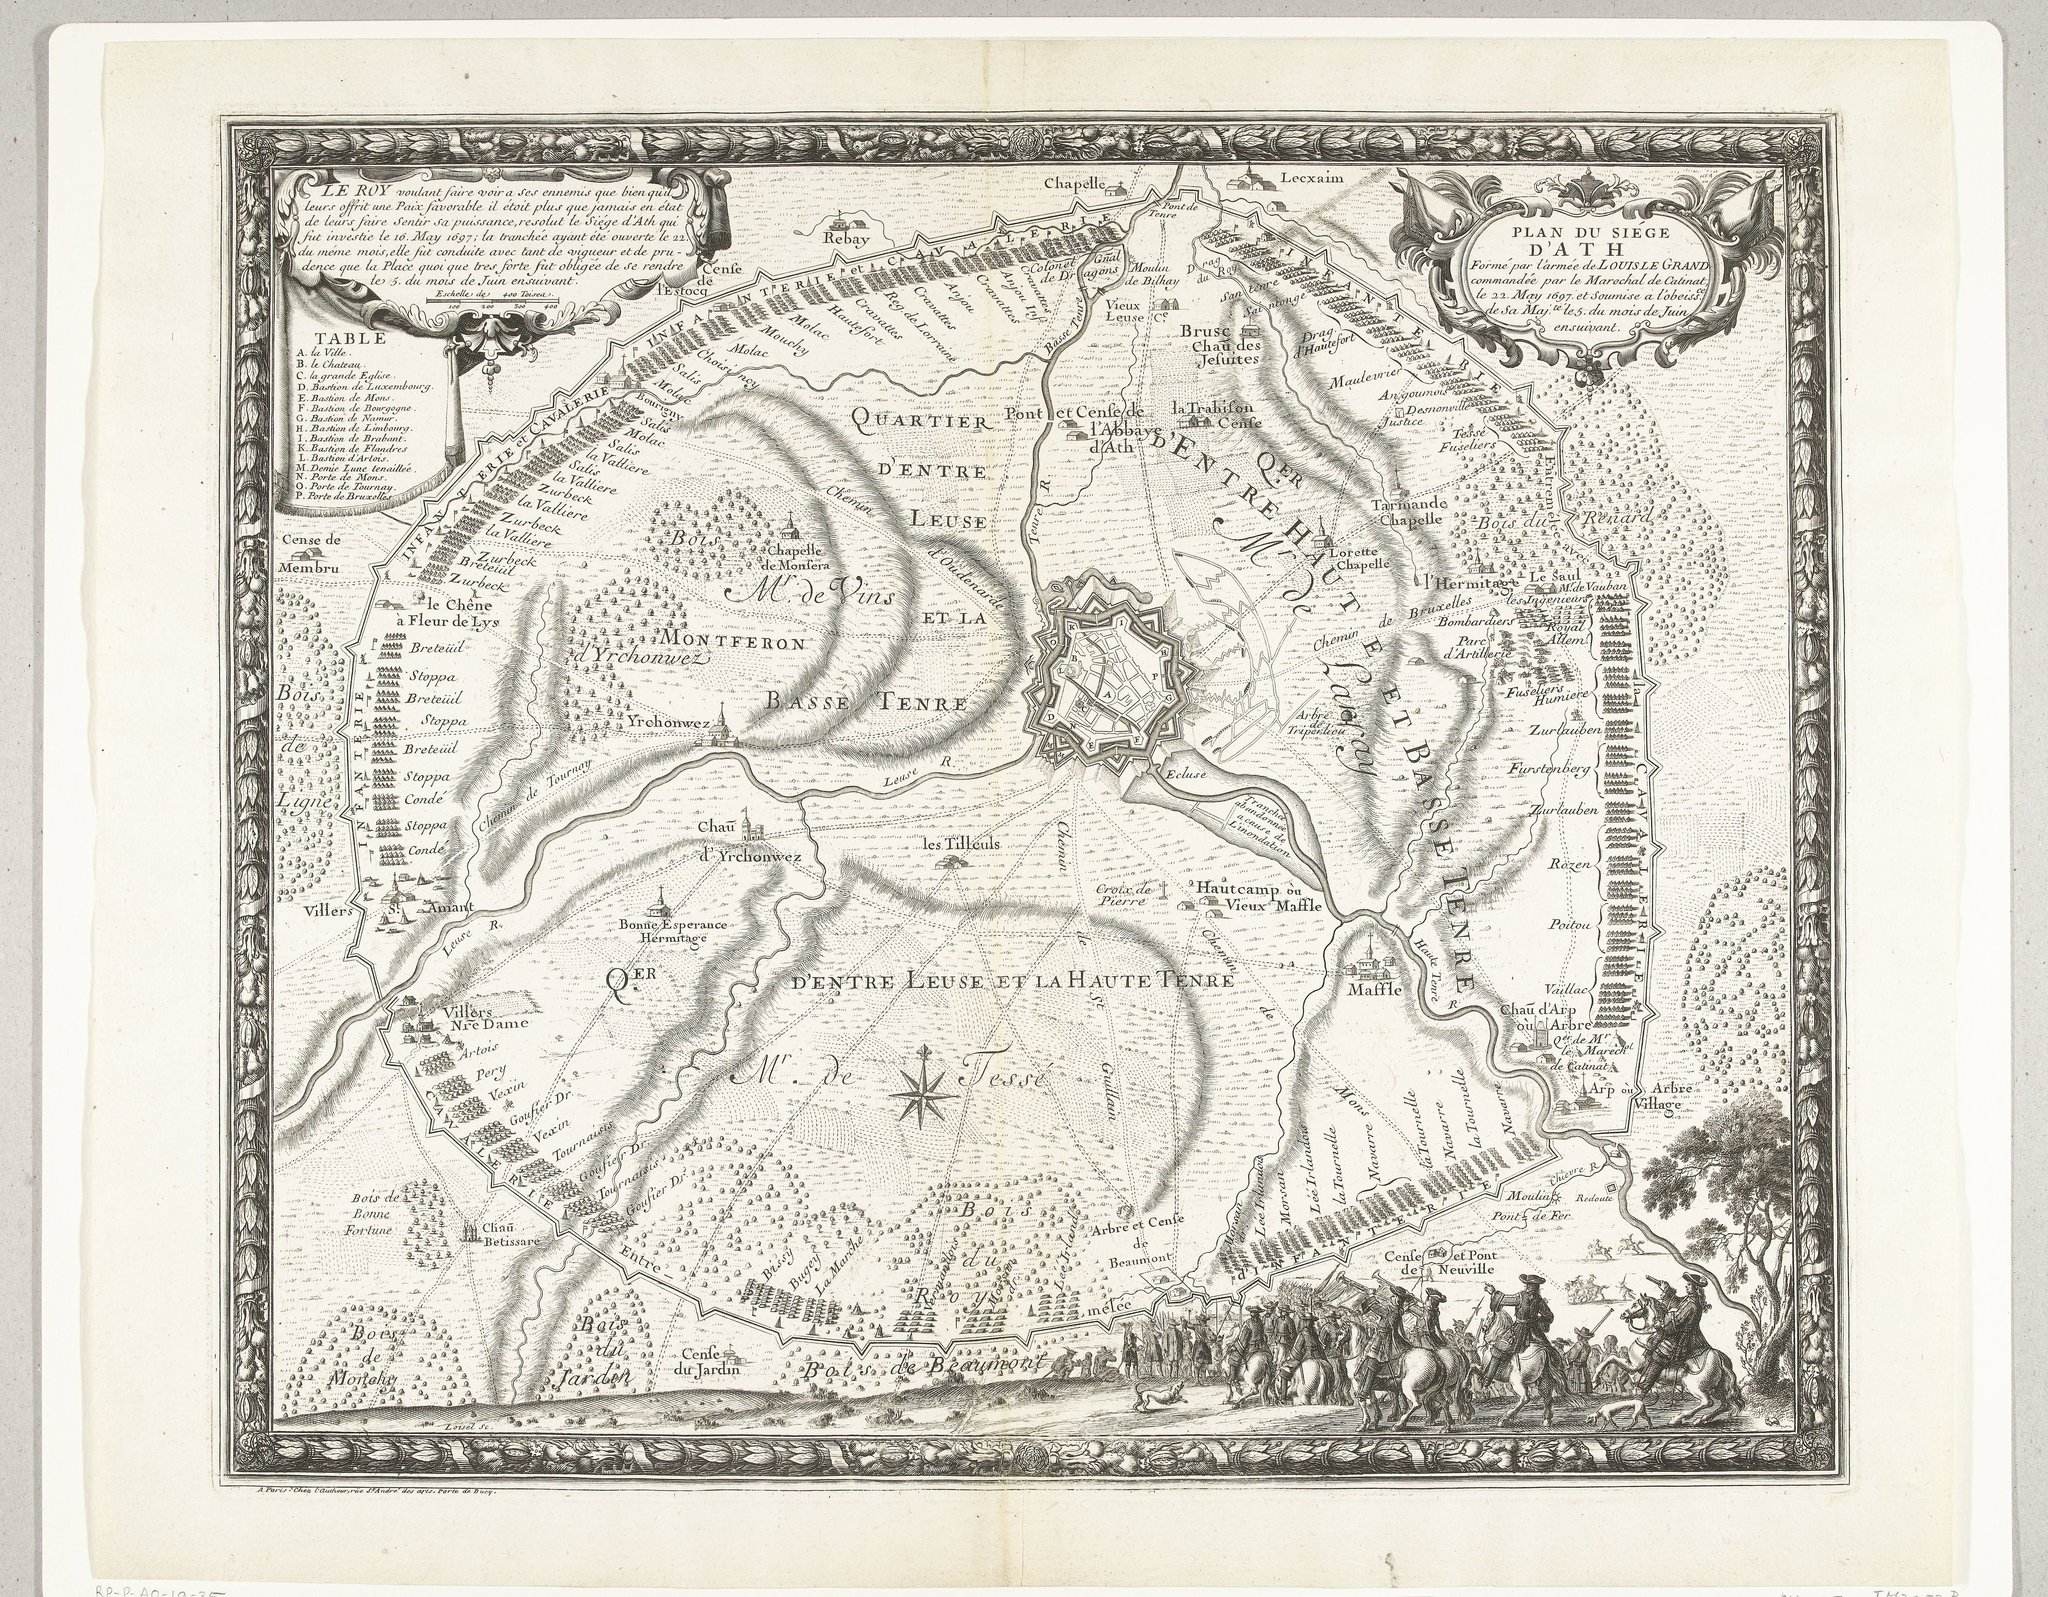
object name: print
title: Beleg van Ath, 1697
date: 1697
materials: paper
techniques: etching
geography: france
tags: lodewijk xiv (koning van frankrijk), maps of separate countries or regions, capture of city (after the siege)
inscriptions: collector's mark: Lugt 195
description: Kaart van de stad Ath en omgeving in Henegouwen tijdens de omsingeling, belegering en inname door het Franse leger, 22 mei-5 juni 1697. Voorstelling in decoratieve rand van bladeren.